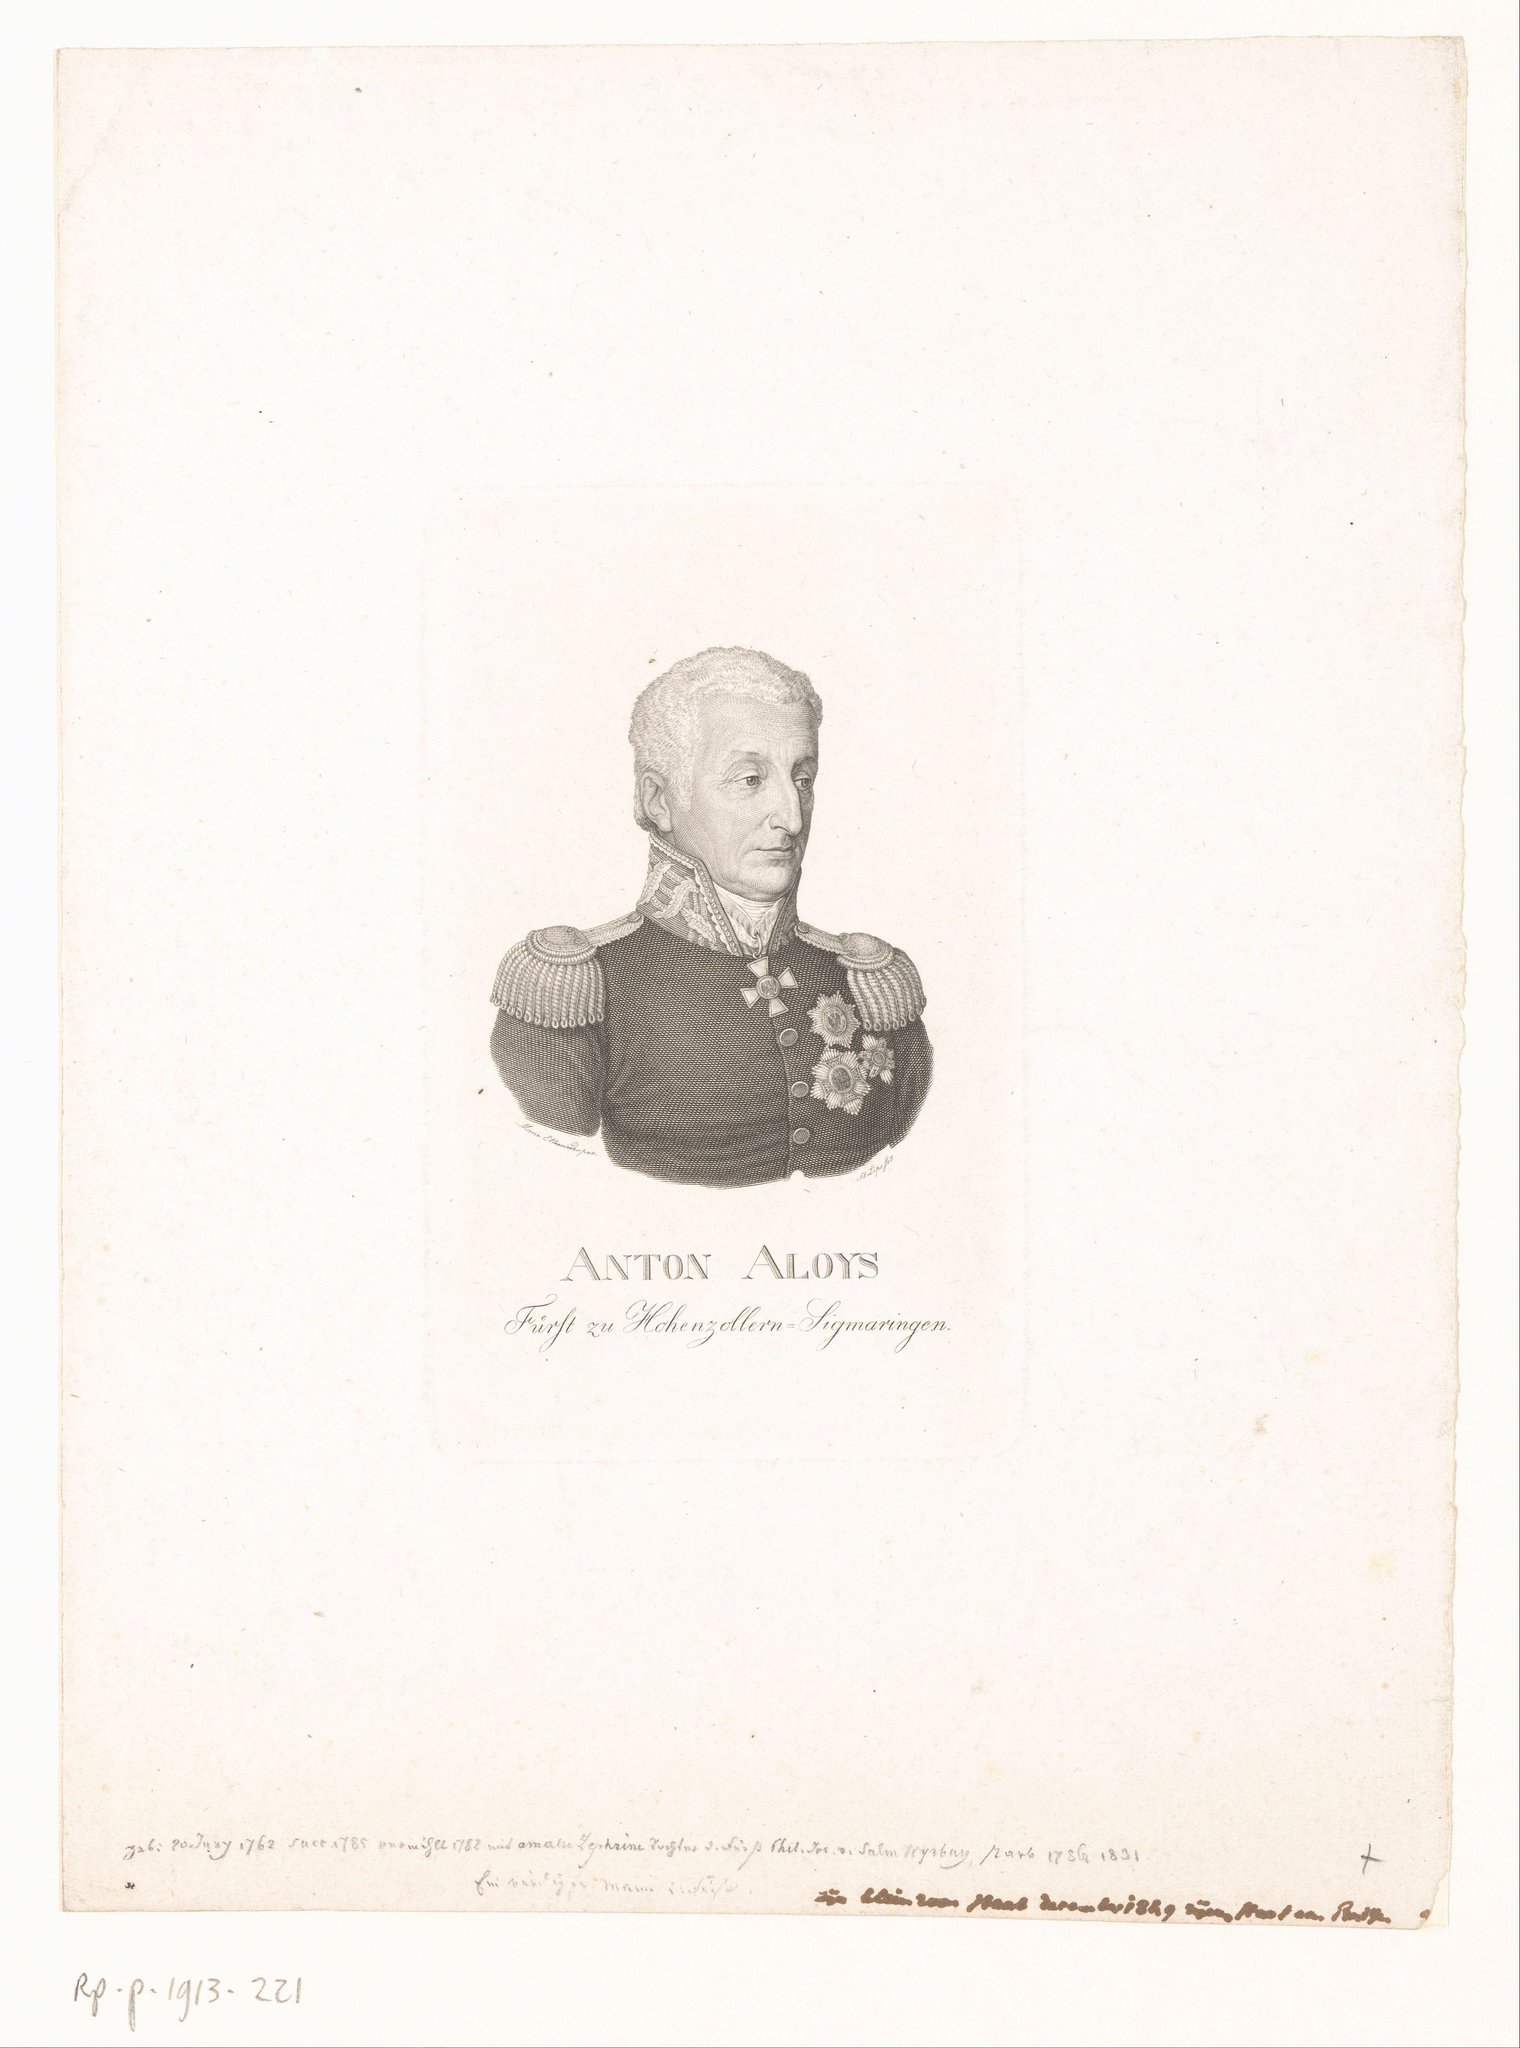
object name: print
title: Portret van Anton Alois van Hohenzollern-Sigmaringen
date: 1768-1817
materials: paper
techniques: engraving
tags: historical persons, medals and other marks of military honour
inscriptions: collector's mark: Lugt 2228